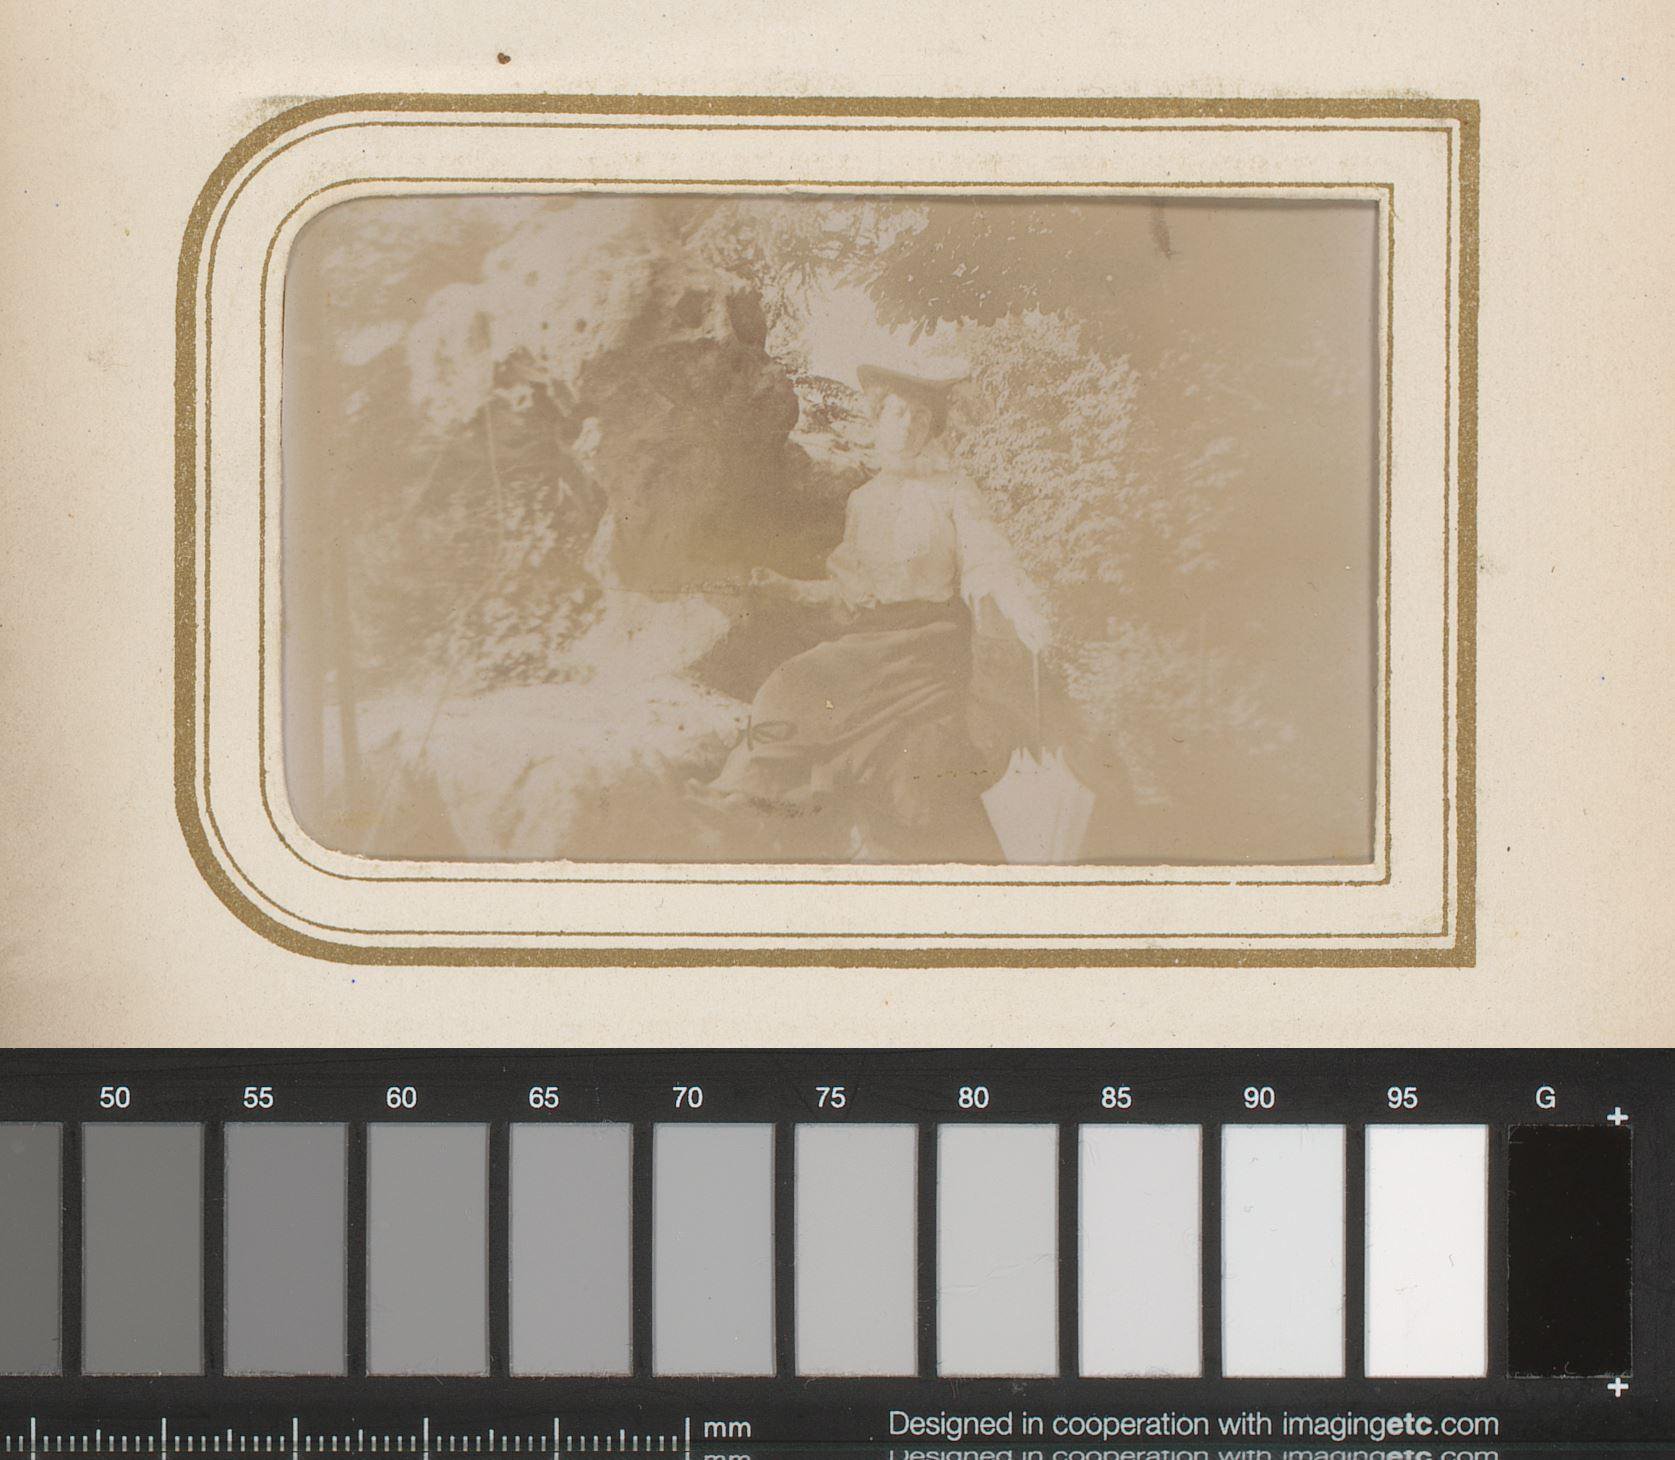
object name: album leaf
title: Portret van een vrouw in een tuin of park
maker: Anonymous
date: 1880-1920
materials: cardboard, photographic support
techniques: gelatin silver print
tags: plants (in general), adult woman, historical persons